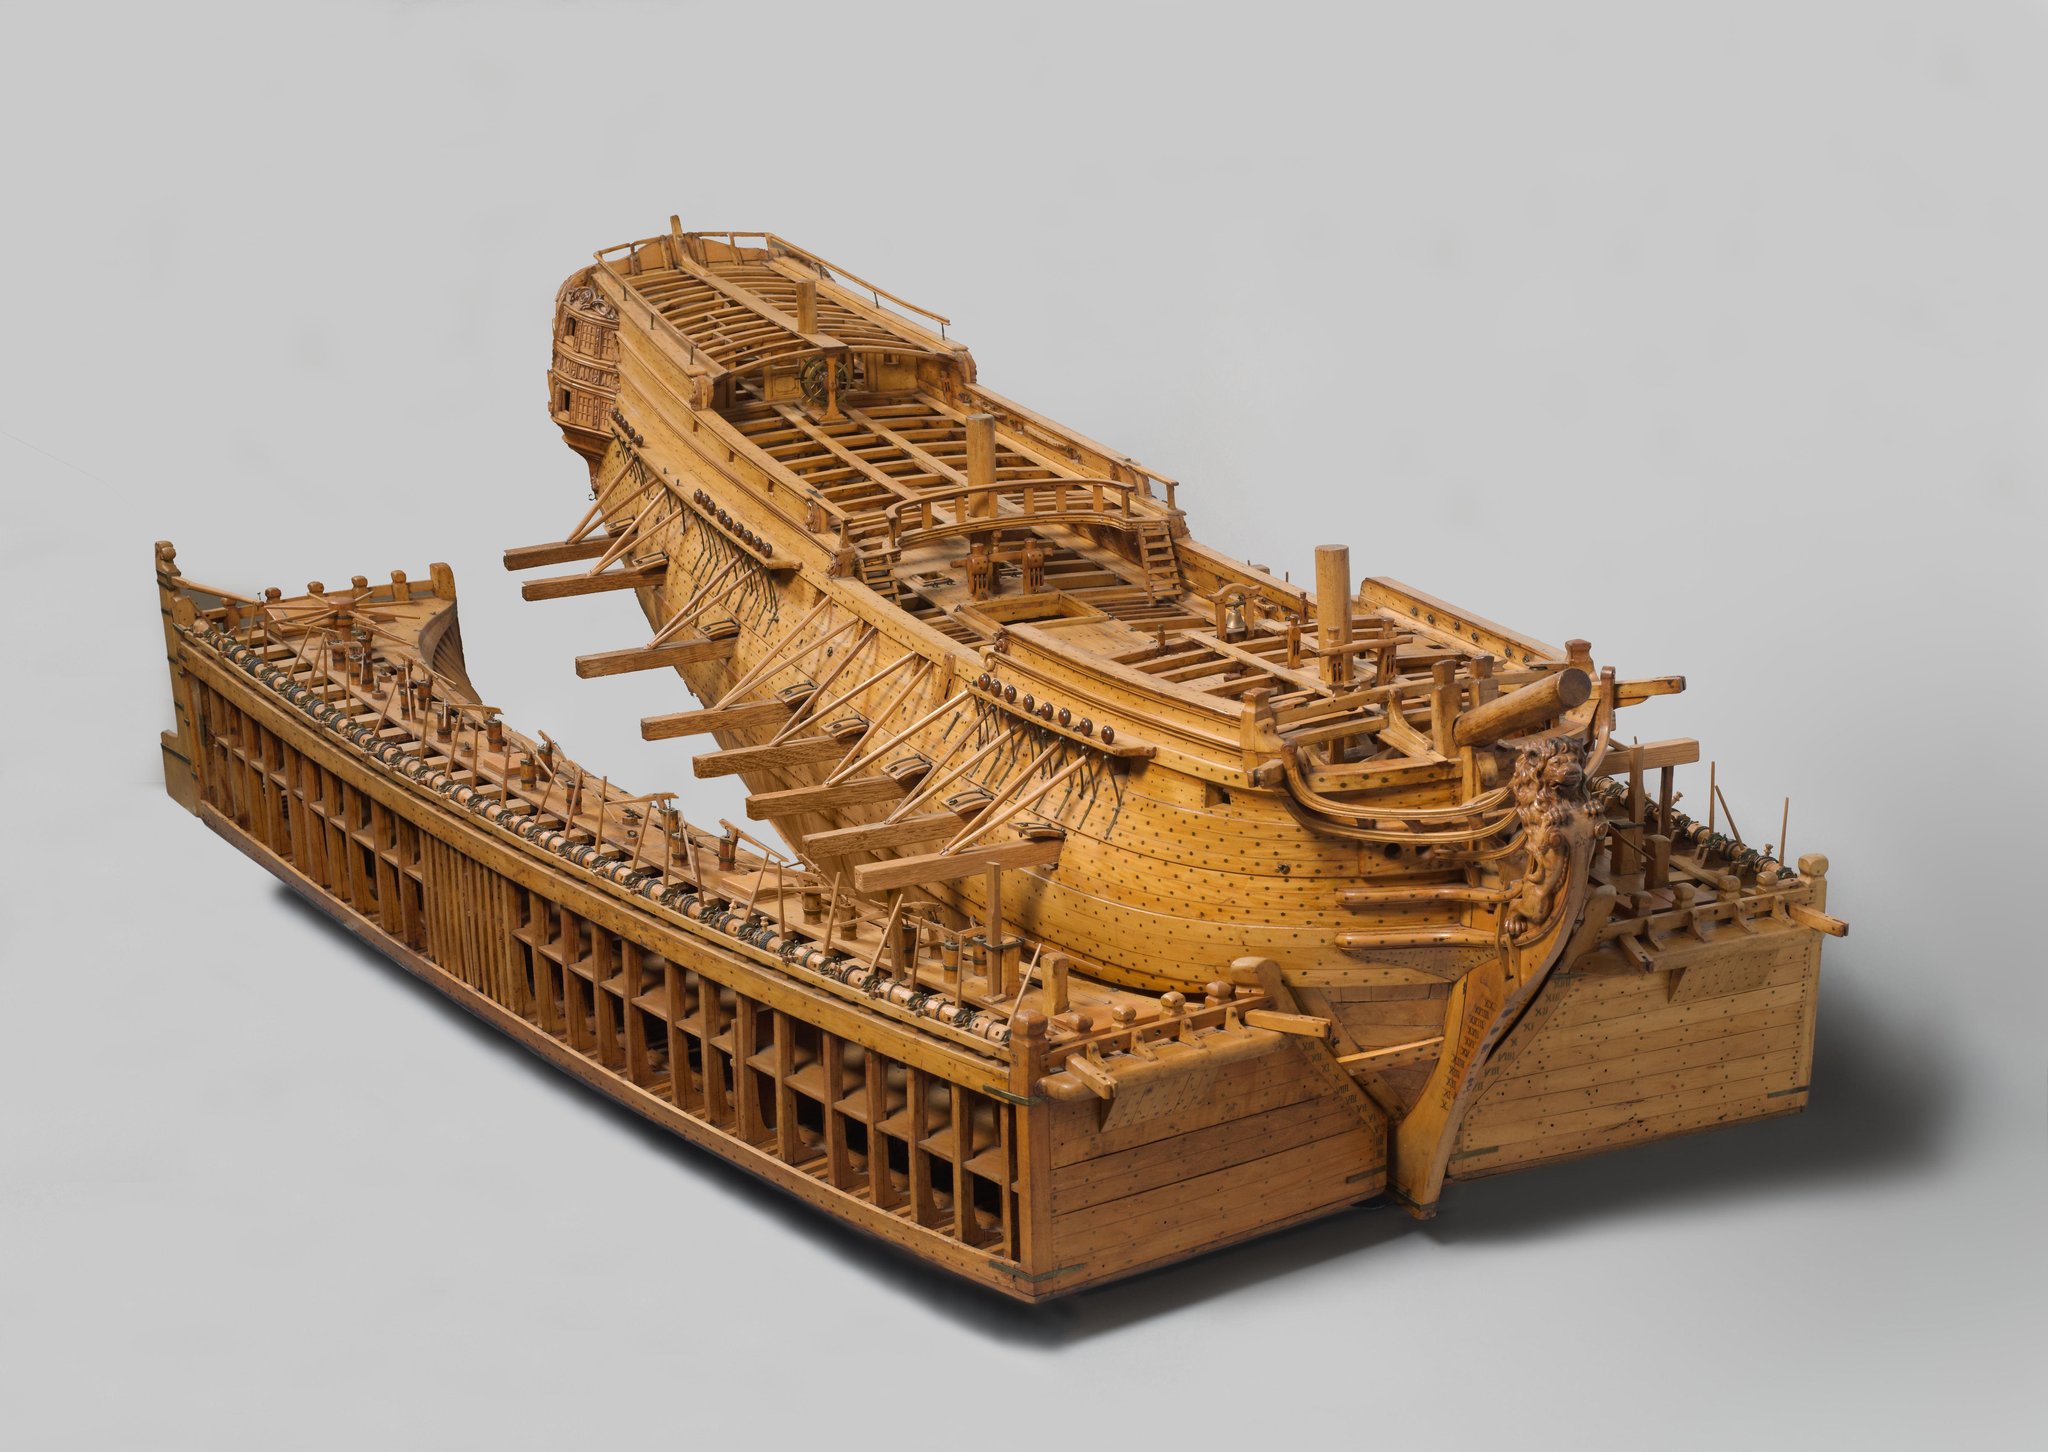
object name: presentation model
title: Model of an East Indiaman in Camels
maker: Anonymous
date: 1742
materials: brass, wood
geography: amsterdam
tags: ship's camel (device used to raise a ship over a bar), ship-model, amsterdam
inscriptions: monogram, on the stern: ‘A VOC’, mark: draught marks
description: Spantmodel van de romp van een Oost-Indiëvaarder op kamelen. Achter en veertig geschutpoorten verdeeld over drie dekken. Vier niveau's: onderdek, tussendek, bakdek en luizenplecht en halfdek, bovencampanje, alle zonder vloerdelen. Het schegbeeld is een leeuw, de kraanbalk aan stuurboord is lager dan die aan bakboord. Gewrongen spiegel met een poort aan bakboord, hol wulf met twee poorten, hek van twee verdiepingen met snijwerk van pilasters, plantmotieven, mythologische figuren (Neptunus en Mercurius) in de hoeken en de wapens van Amsterdam en de Kamer van de VOC in Amsterdam; zijgalerijen van twee verdiepingen met snijwerk. Recht roer met vierkante roerkoning, zogklampen, luiwagen op het onderdek, stuurwiel onder de bovencampanje voor de bezaansmast. Het model is voorzien van een mechanische ventilator op het onderdek, een dubbele ankerbeting, een pomp en een kombuis onder het bakdek en een spil en twee pompen onder het halfdek. Het is voorzien van alle rusten met jufferblokken, de grote rust en bezaansrust lopen door. De gladboordige huid is aan stuurboord onder de barkhouten weggelaten en laat negendelige spanten zien. Binnenin is het model aan stuurboord gewegerd, terwijl aan bakboord wegering en dekknieën weggelaten zijn. De zeeg loopt op naar beide uiteinden, twee barkhouten. Rondspant. De rondhouten zijn net boven dek afgezaagd. Schaal 1:30 (schatting).